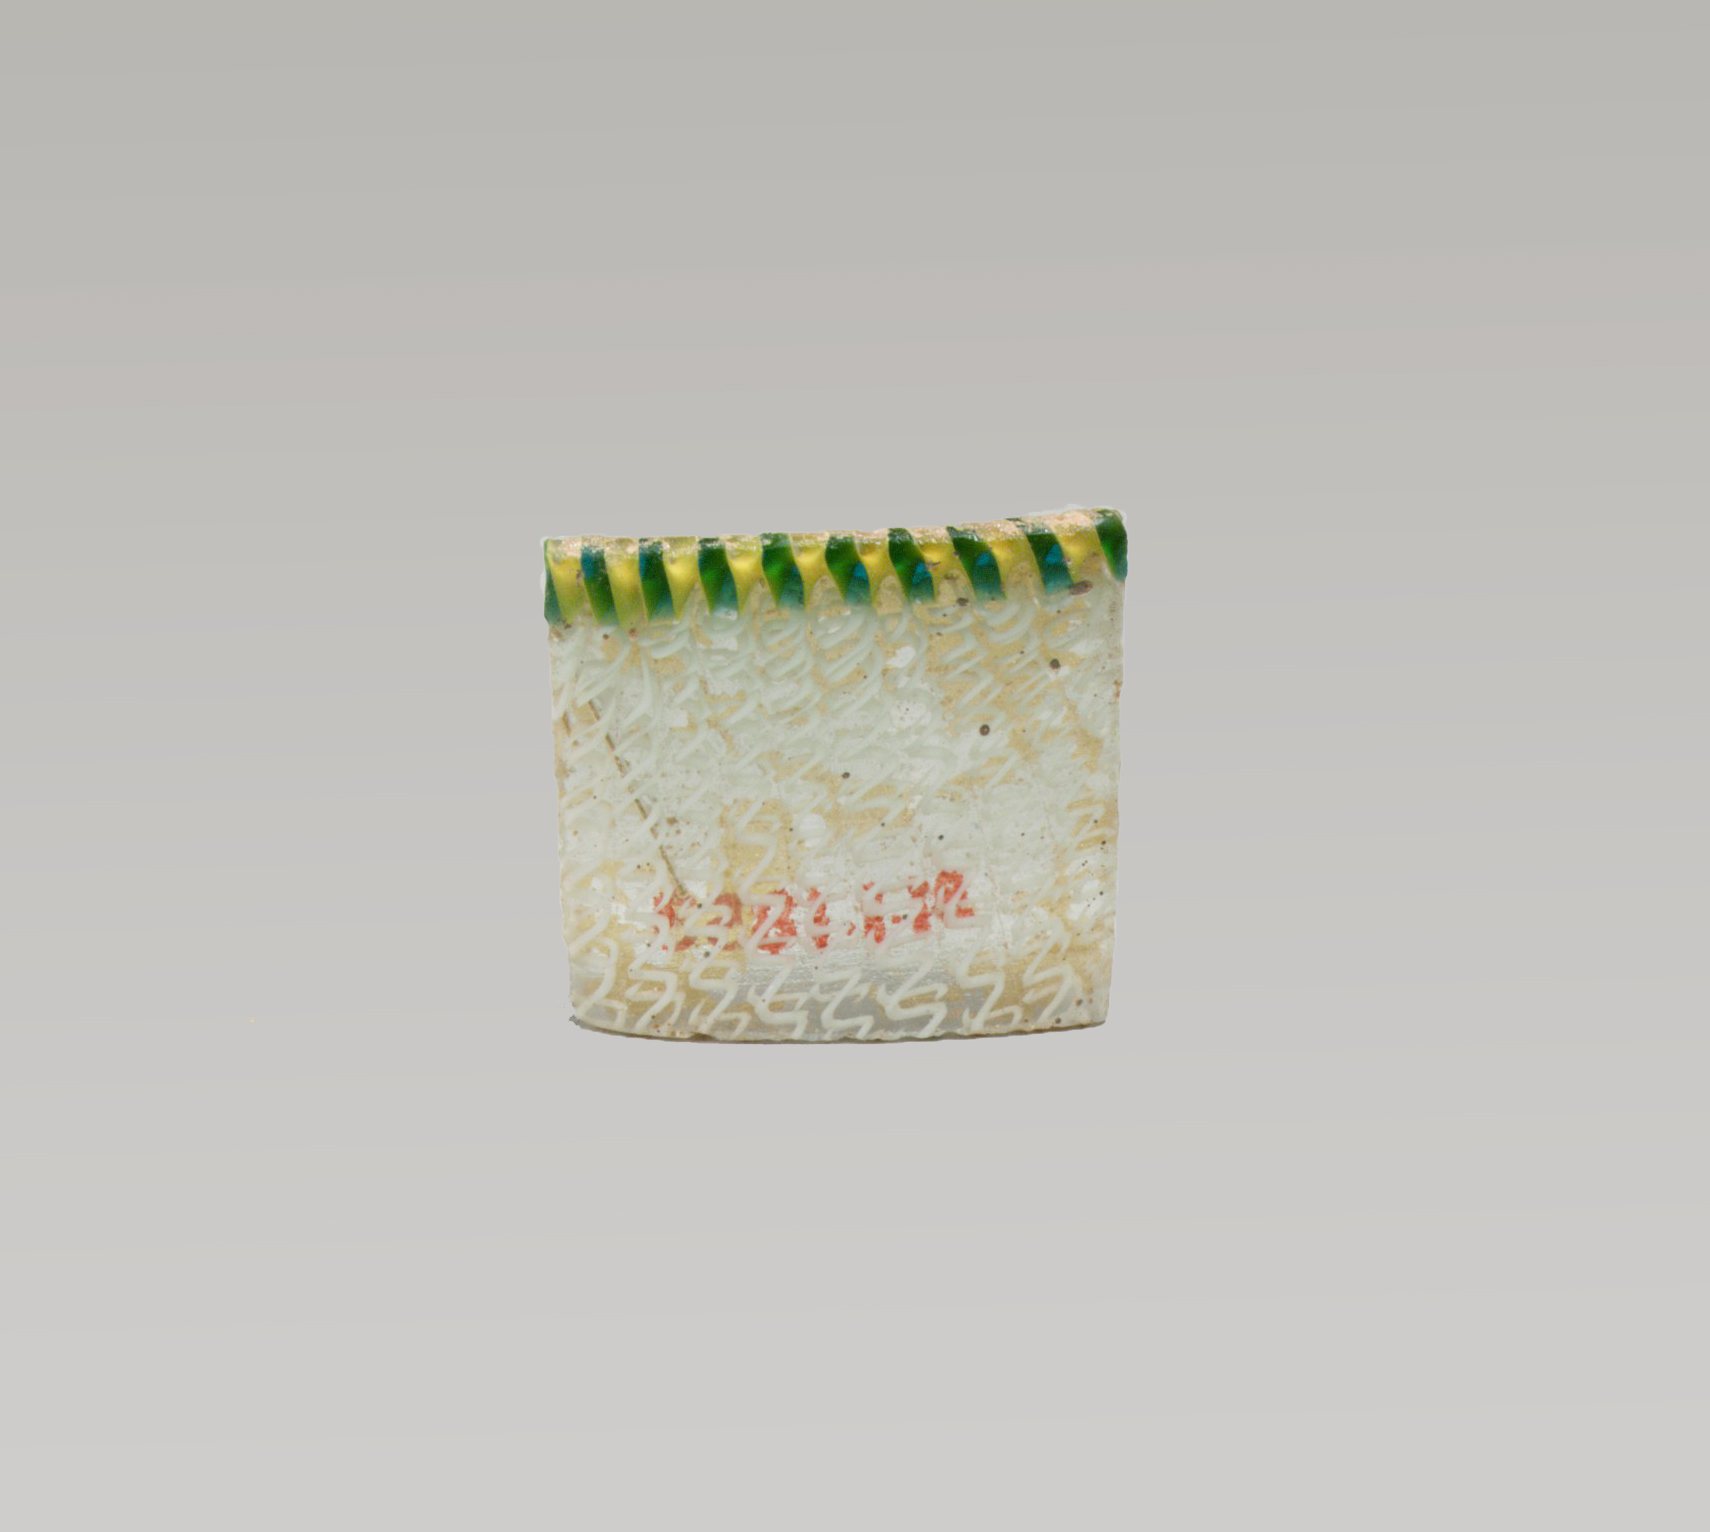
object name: fragment, network mosaic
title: Glass network mosaic fragment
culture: roman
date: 34 BCE-33 CE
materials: glass